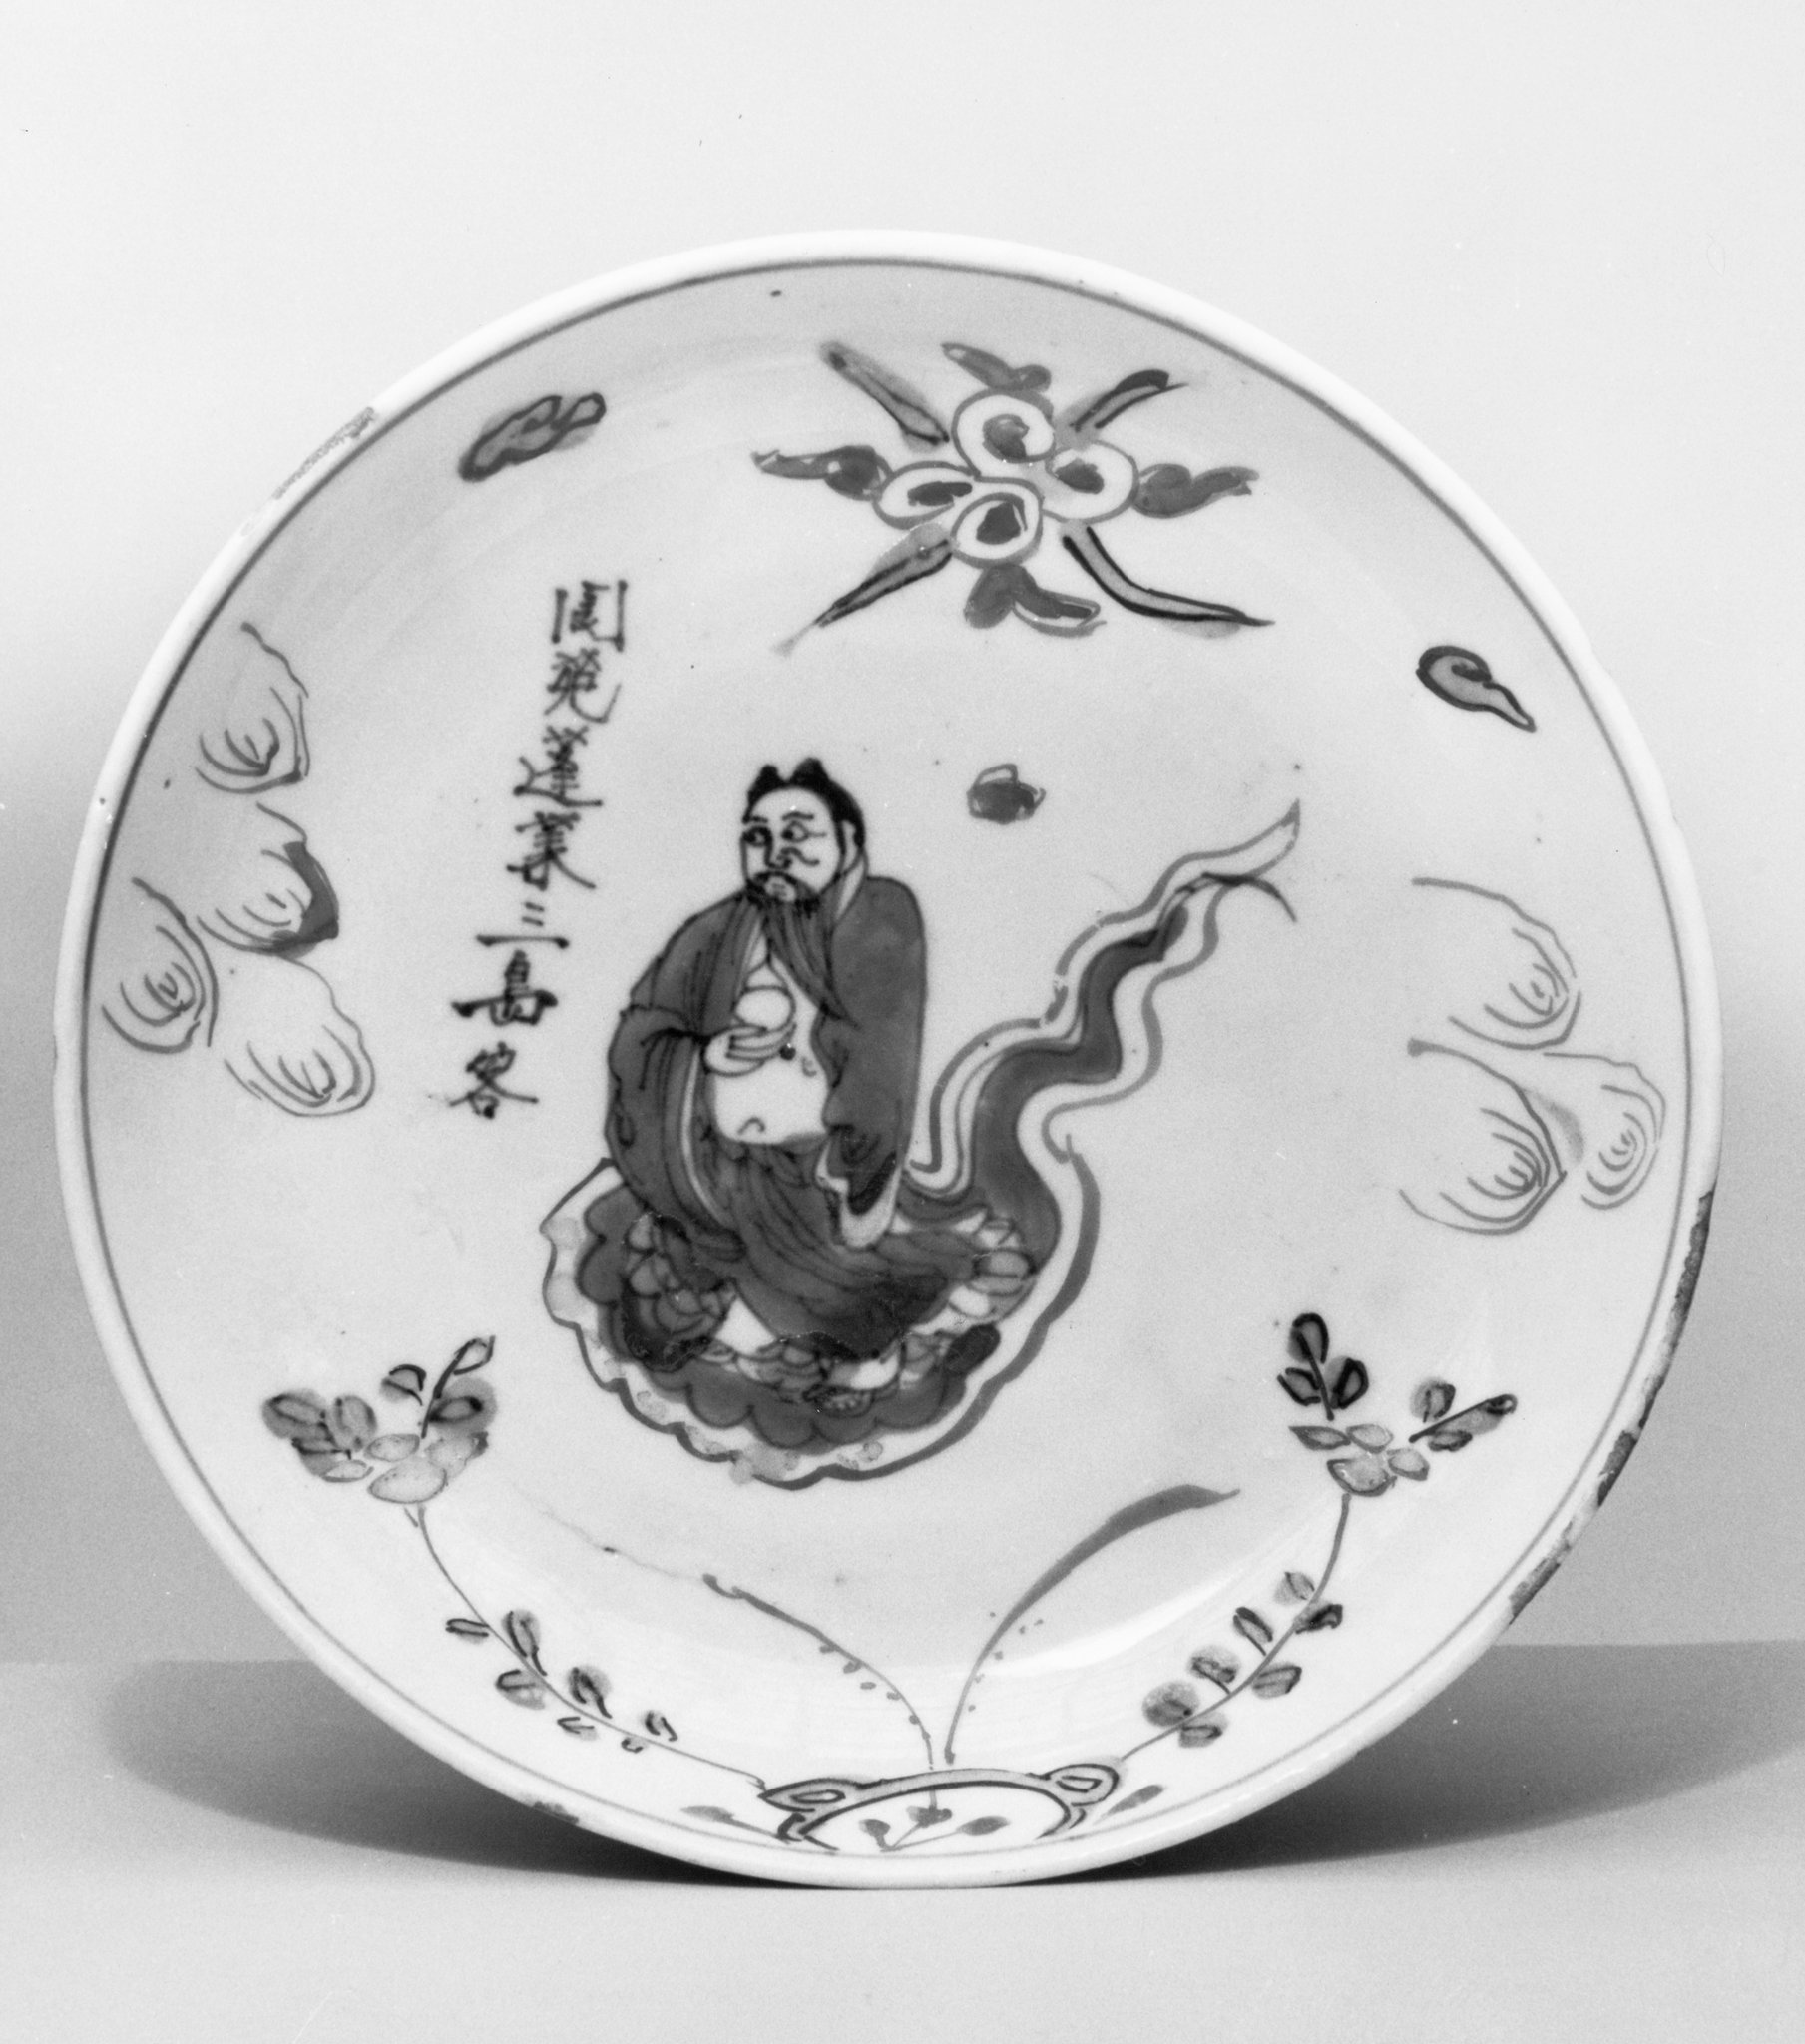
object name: dish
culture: chinese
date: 1621-1627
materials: enamel, porcelain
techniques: overglaze, painting, polychrome, underglaze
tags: men